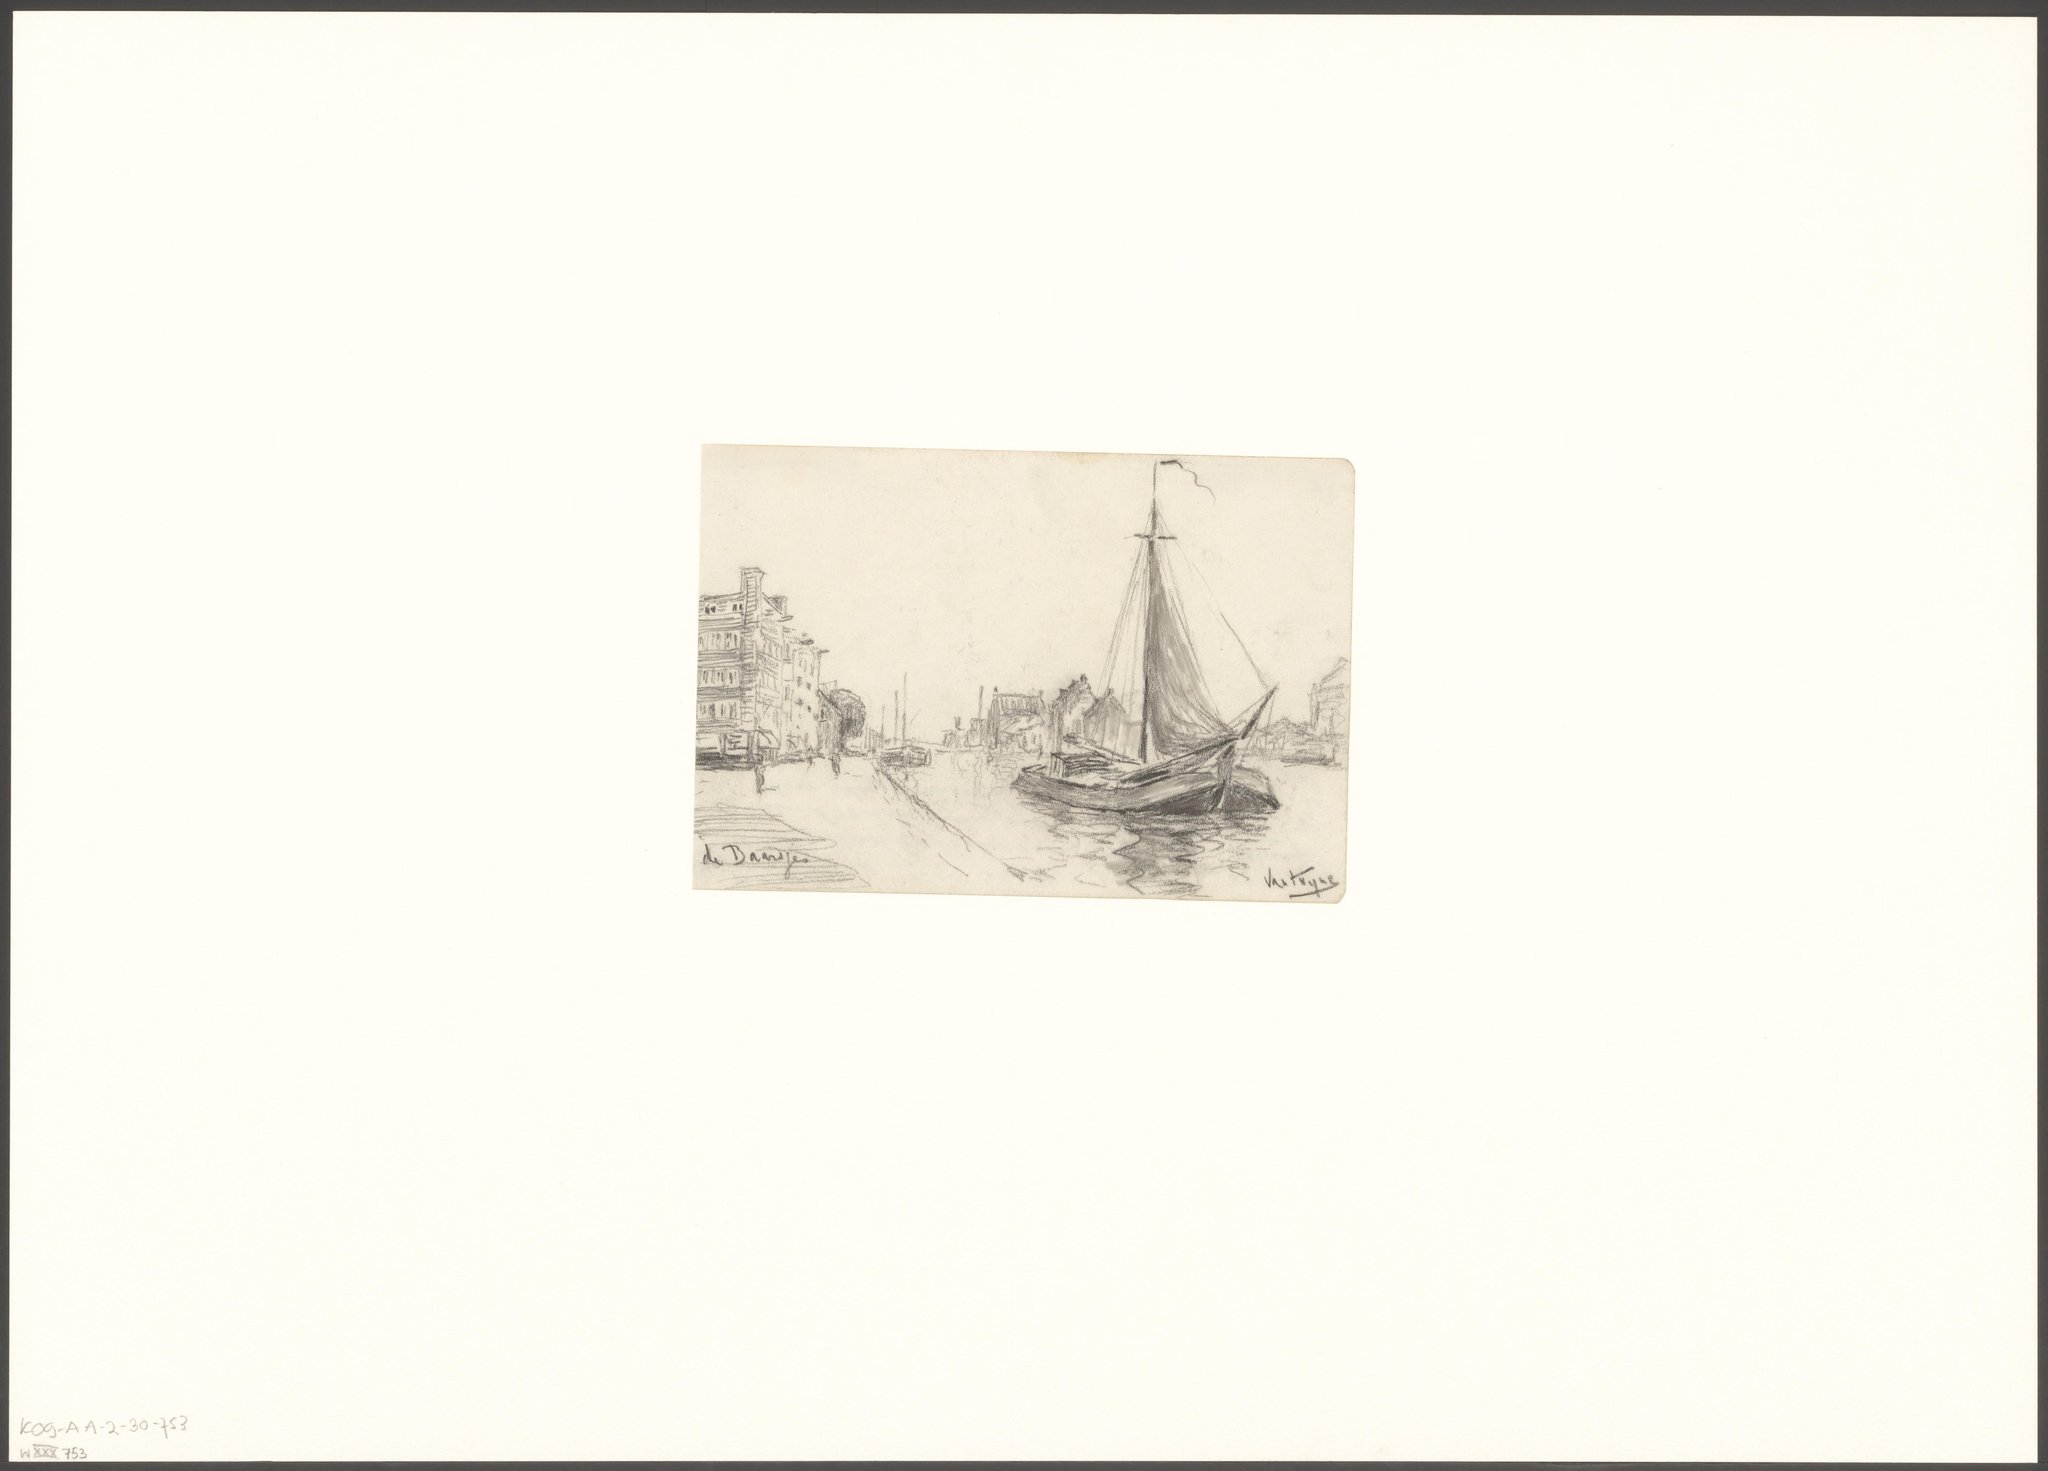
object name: drawing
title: Gezicht op de Kostverlorenvaart gezien vanaf Baarsjesweg, hoek Chasséstraat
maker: anthonie van teijn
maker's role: draughtsman, painter, print maker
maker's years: 1863-1943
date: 1906-1927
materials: chalk, paper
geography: amsterdam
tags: sailing-ship, sailing-boat, city-view in general; 'veduta', canal, street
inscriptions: inscription: ‘de Baarsjes’, collector's mark: Lugt 800a, signature: ‘VanTeyne’, inscription: ‘De Kostverlorenvaart. gezien (...) Juni 1927 / vanEck’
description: Tekening binnen de Atlas Van Eck ingedeeld op wijknummer 30.